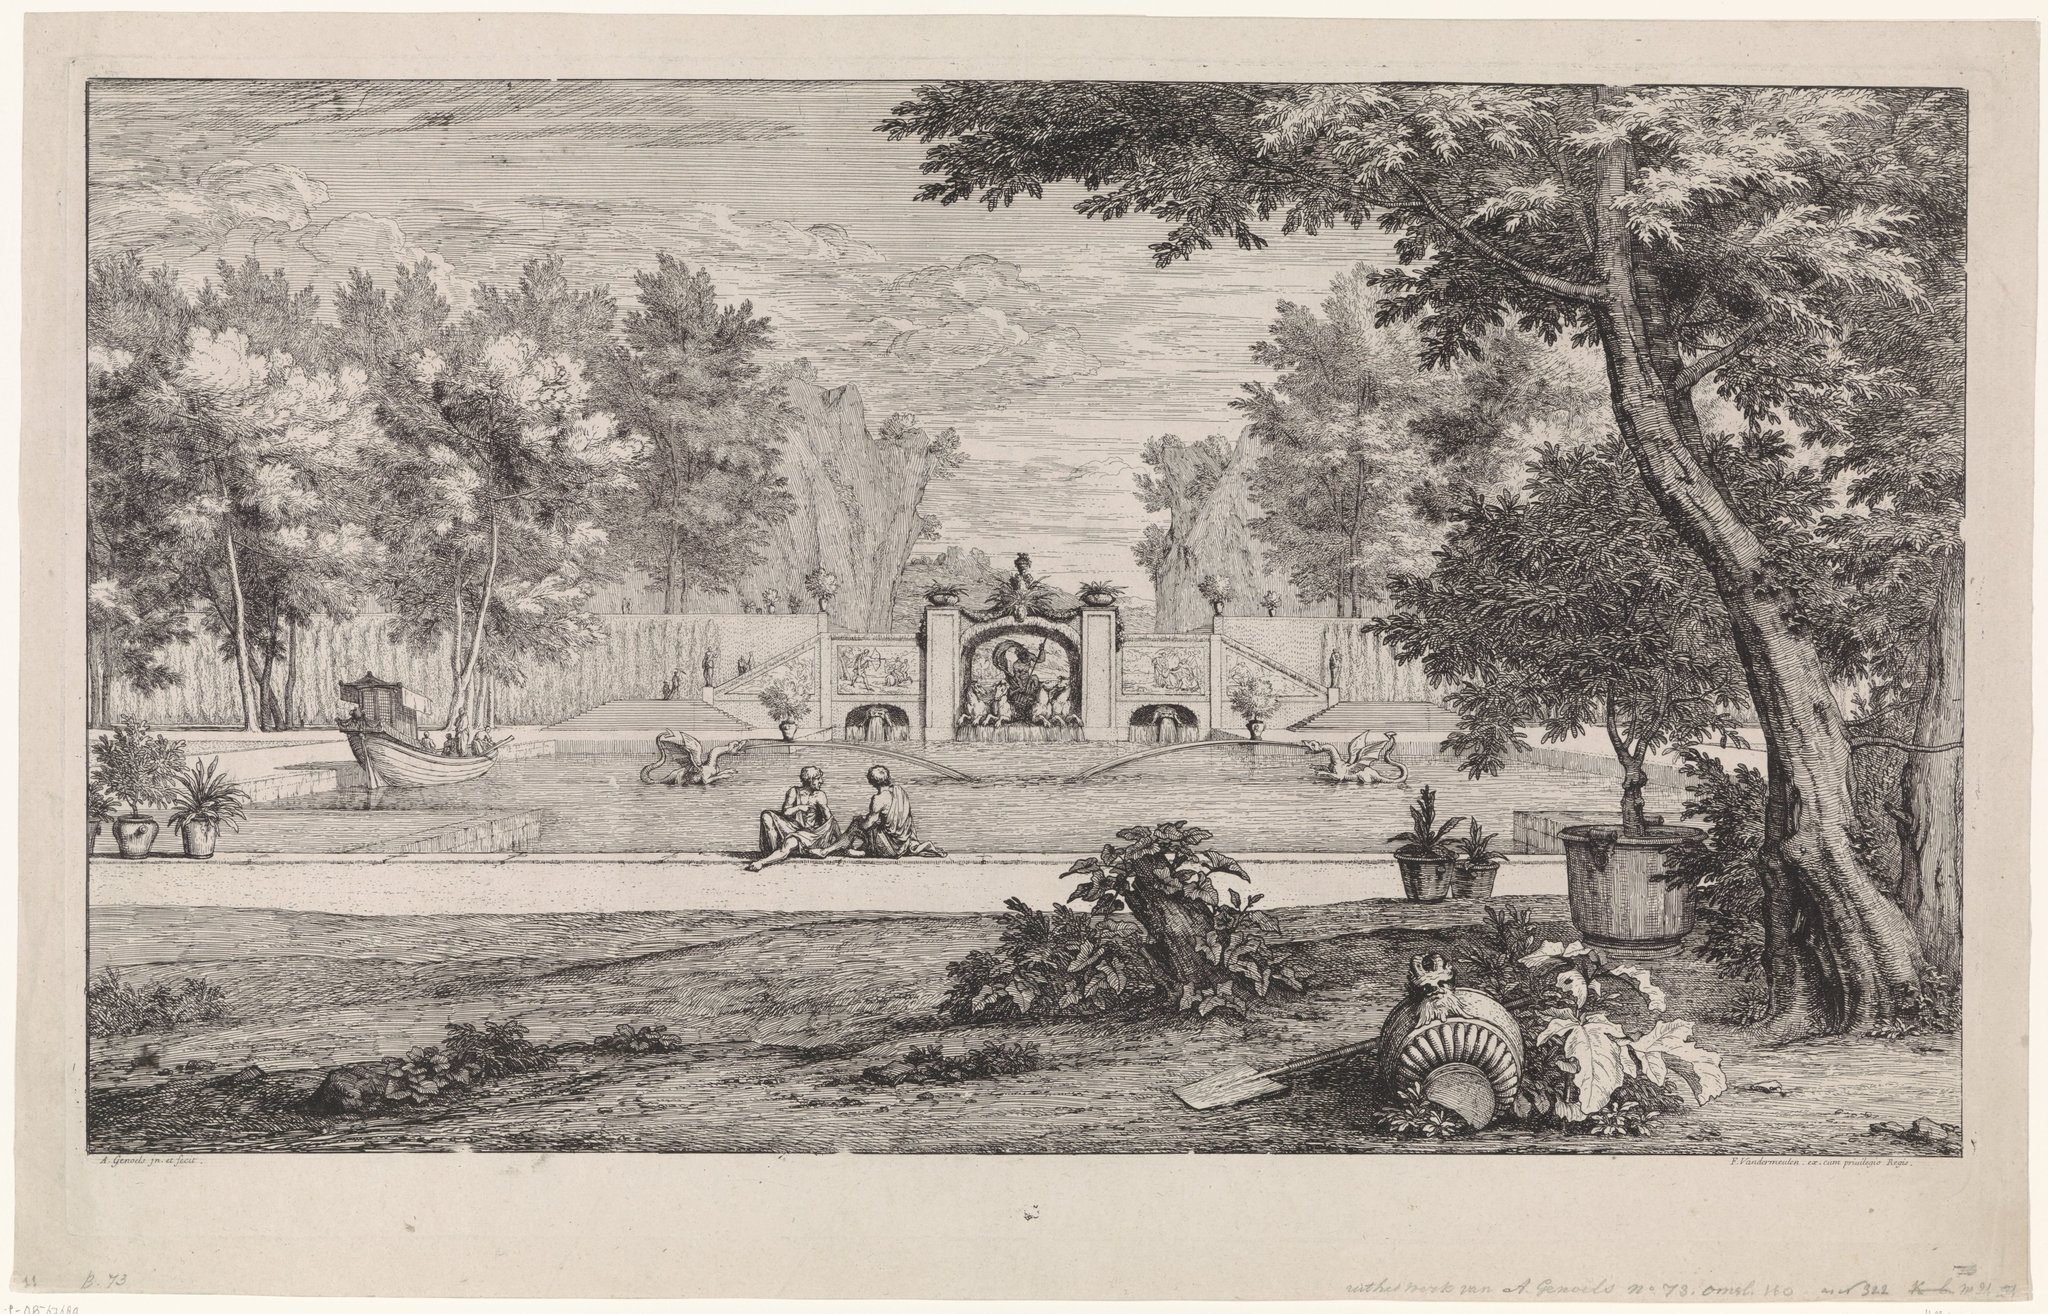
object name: print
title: Gezicht op een tuin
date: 1650-1690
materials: paper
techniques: etching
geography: netherlands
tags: garden fountain, french or architectonic garden; formal garden, rowing-boat, canoe, etc., garden pond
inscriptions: collector's mark: Lugt 240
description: Een vijver met fontein en een waterval in een architectonische tuin. Op de voorgrond zitten twee mannen aan de rand van de vijver. Links een bootje.